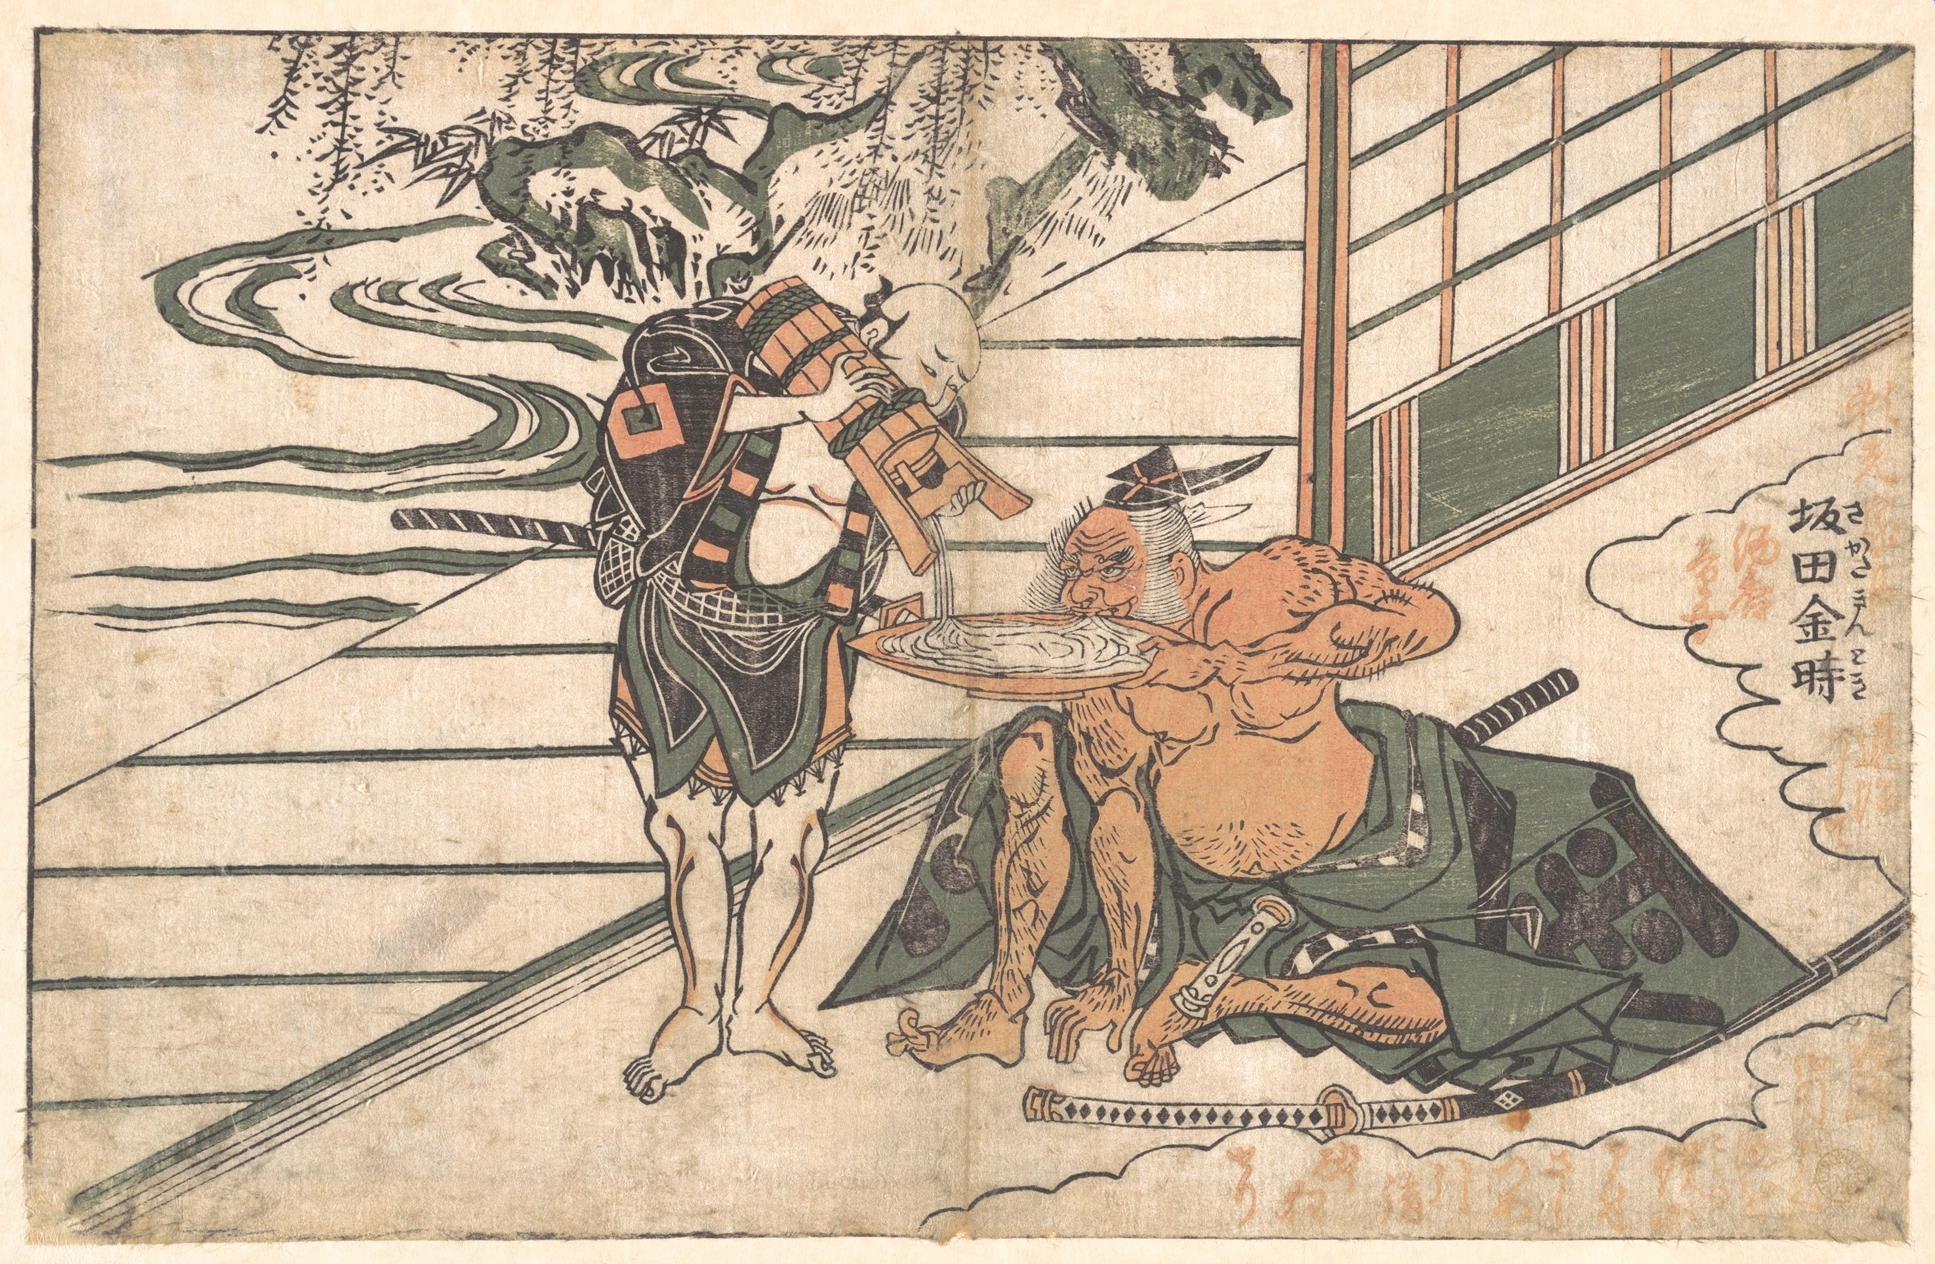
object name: print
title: Legendary Strongman Sakata Kinpira (Kintoki) Drinking Sake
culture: japanese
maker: ishikawa toyonobu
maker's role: artist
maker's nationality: japanese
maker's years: 1711-1785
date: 1750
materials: ink, paper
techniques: woodblock print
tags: swords,men,trees,drinking,actors